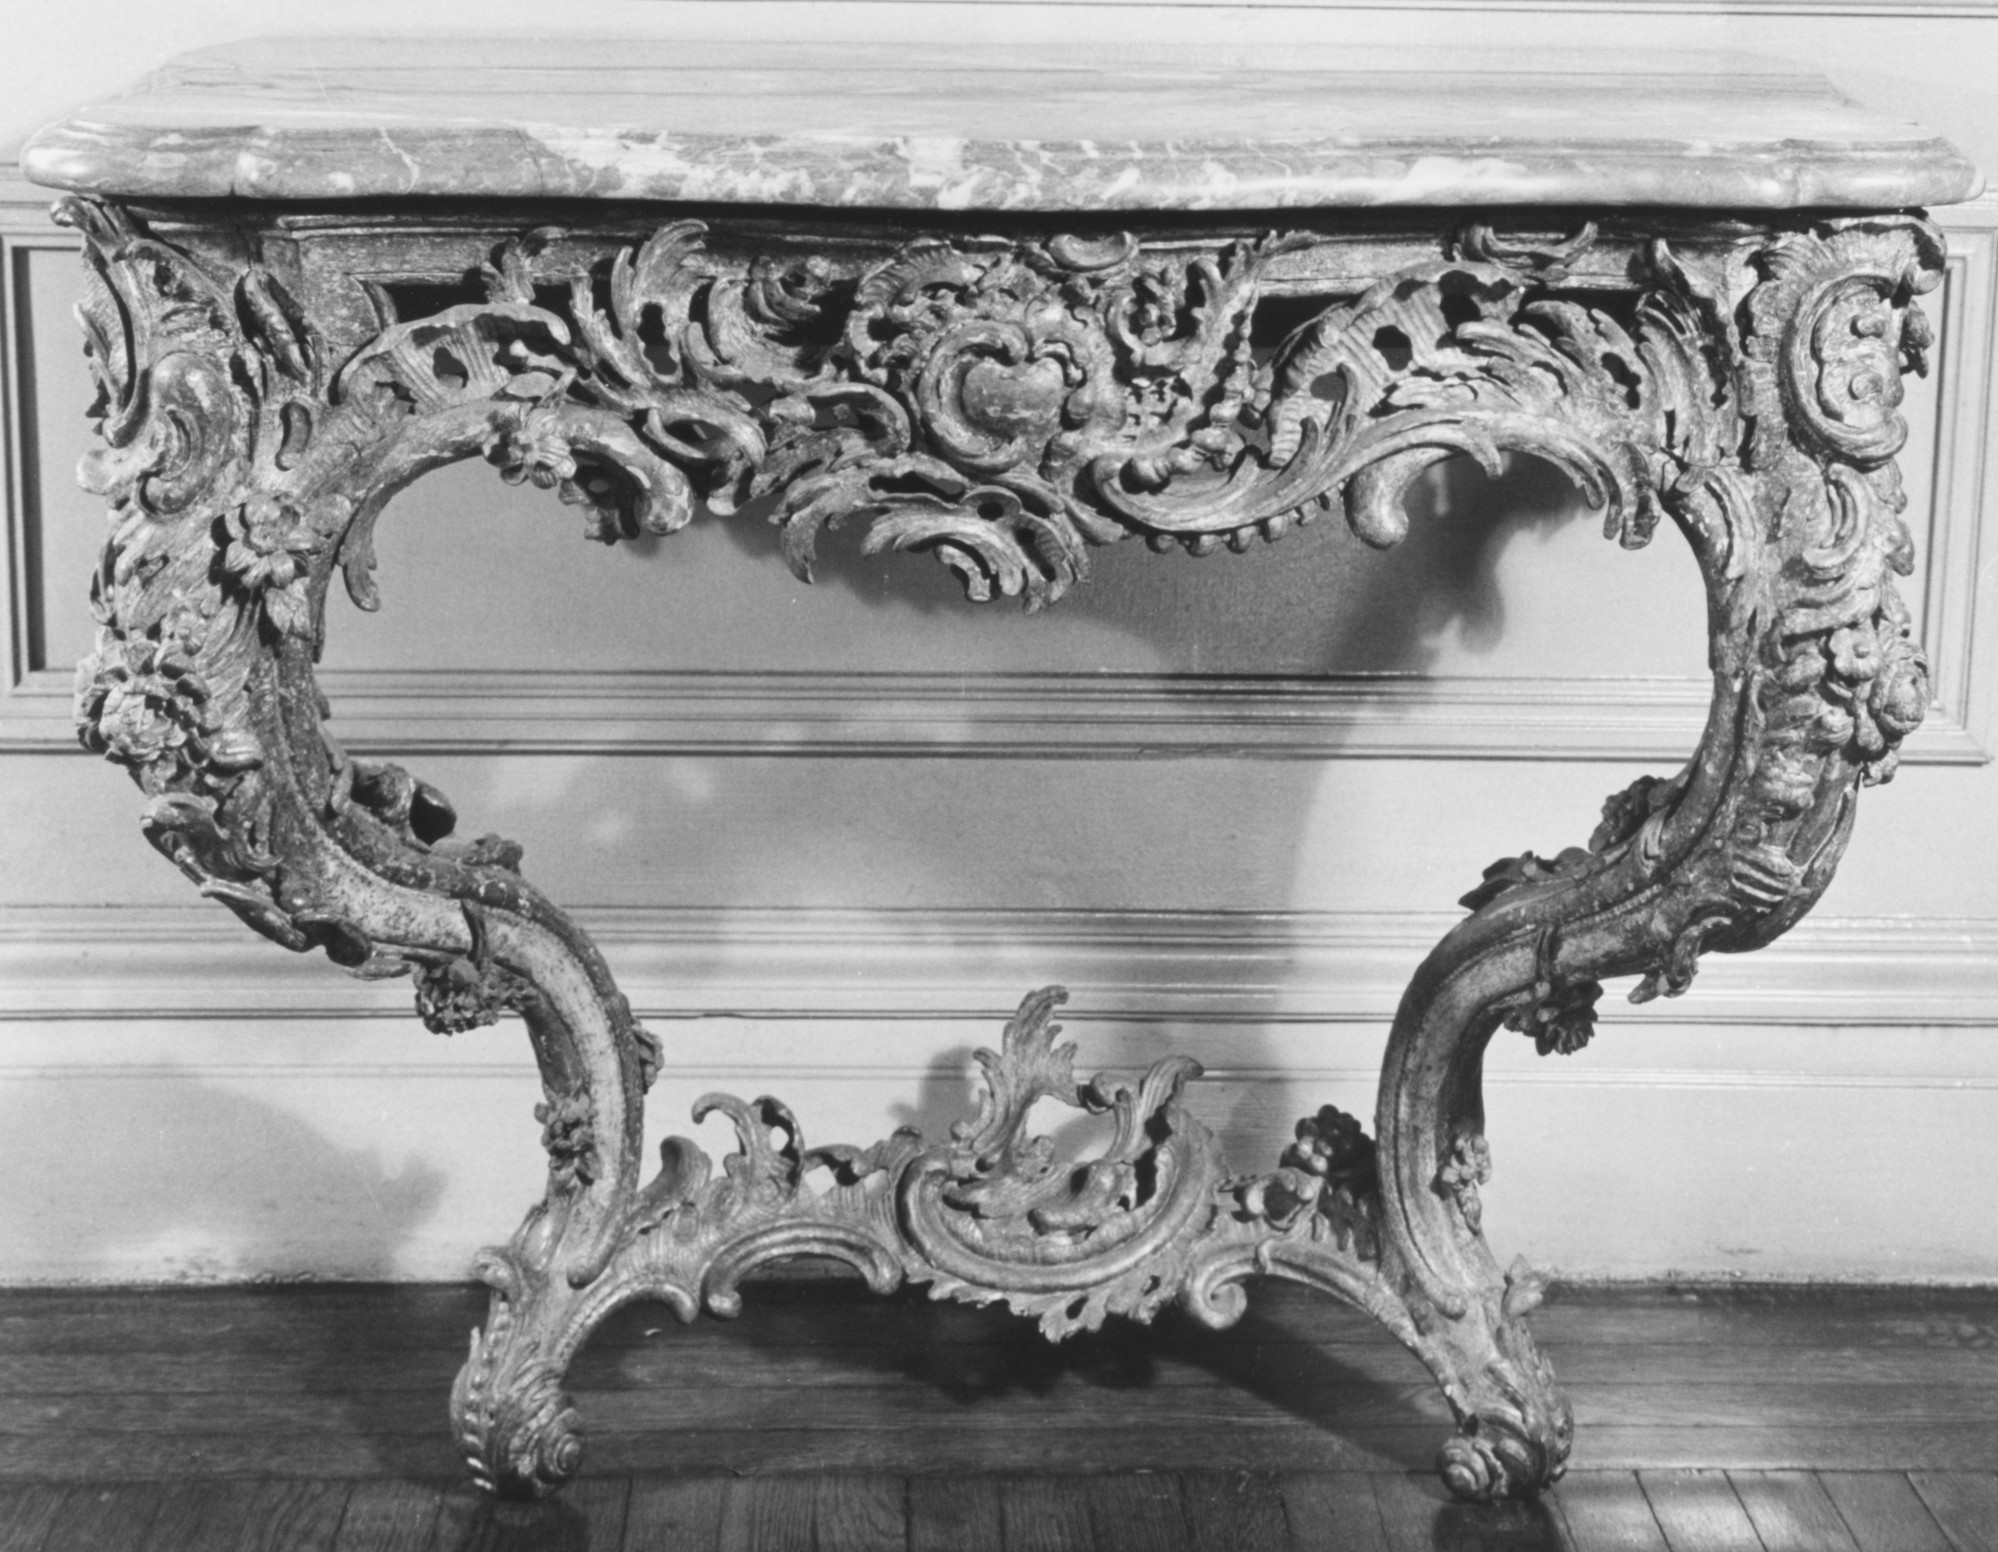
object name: console table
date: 1760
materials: marble, wood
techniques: carving, silvered